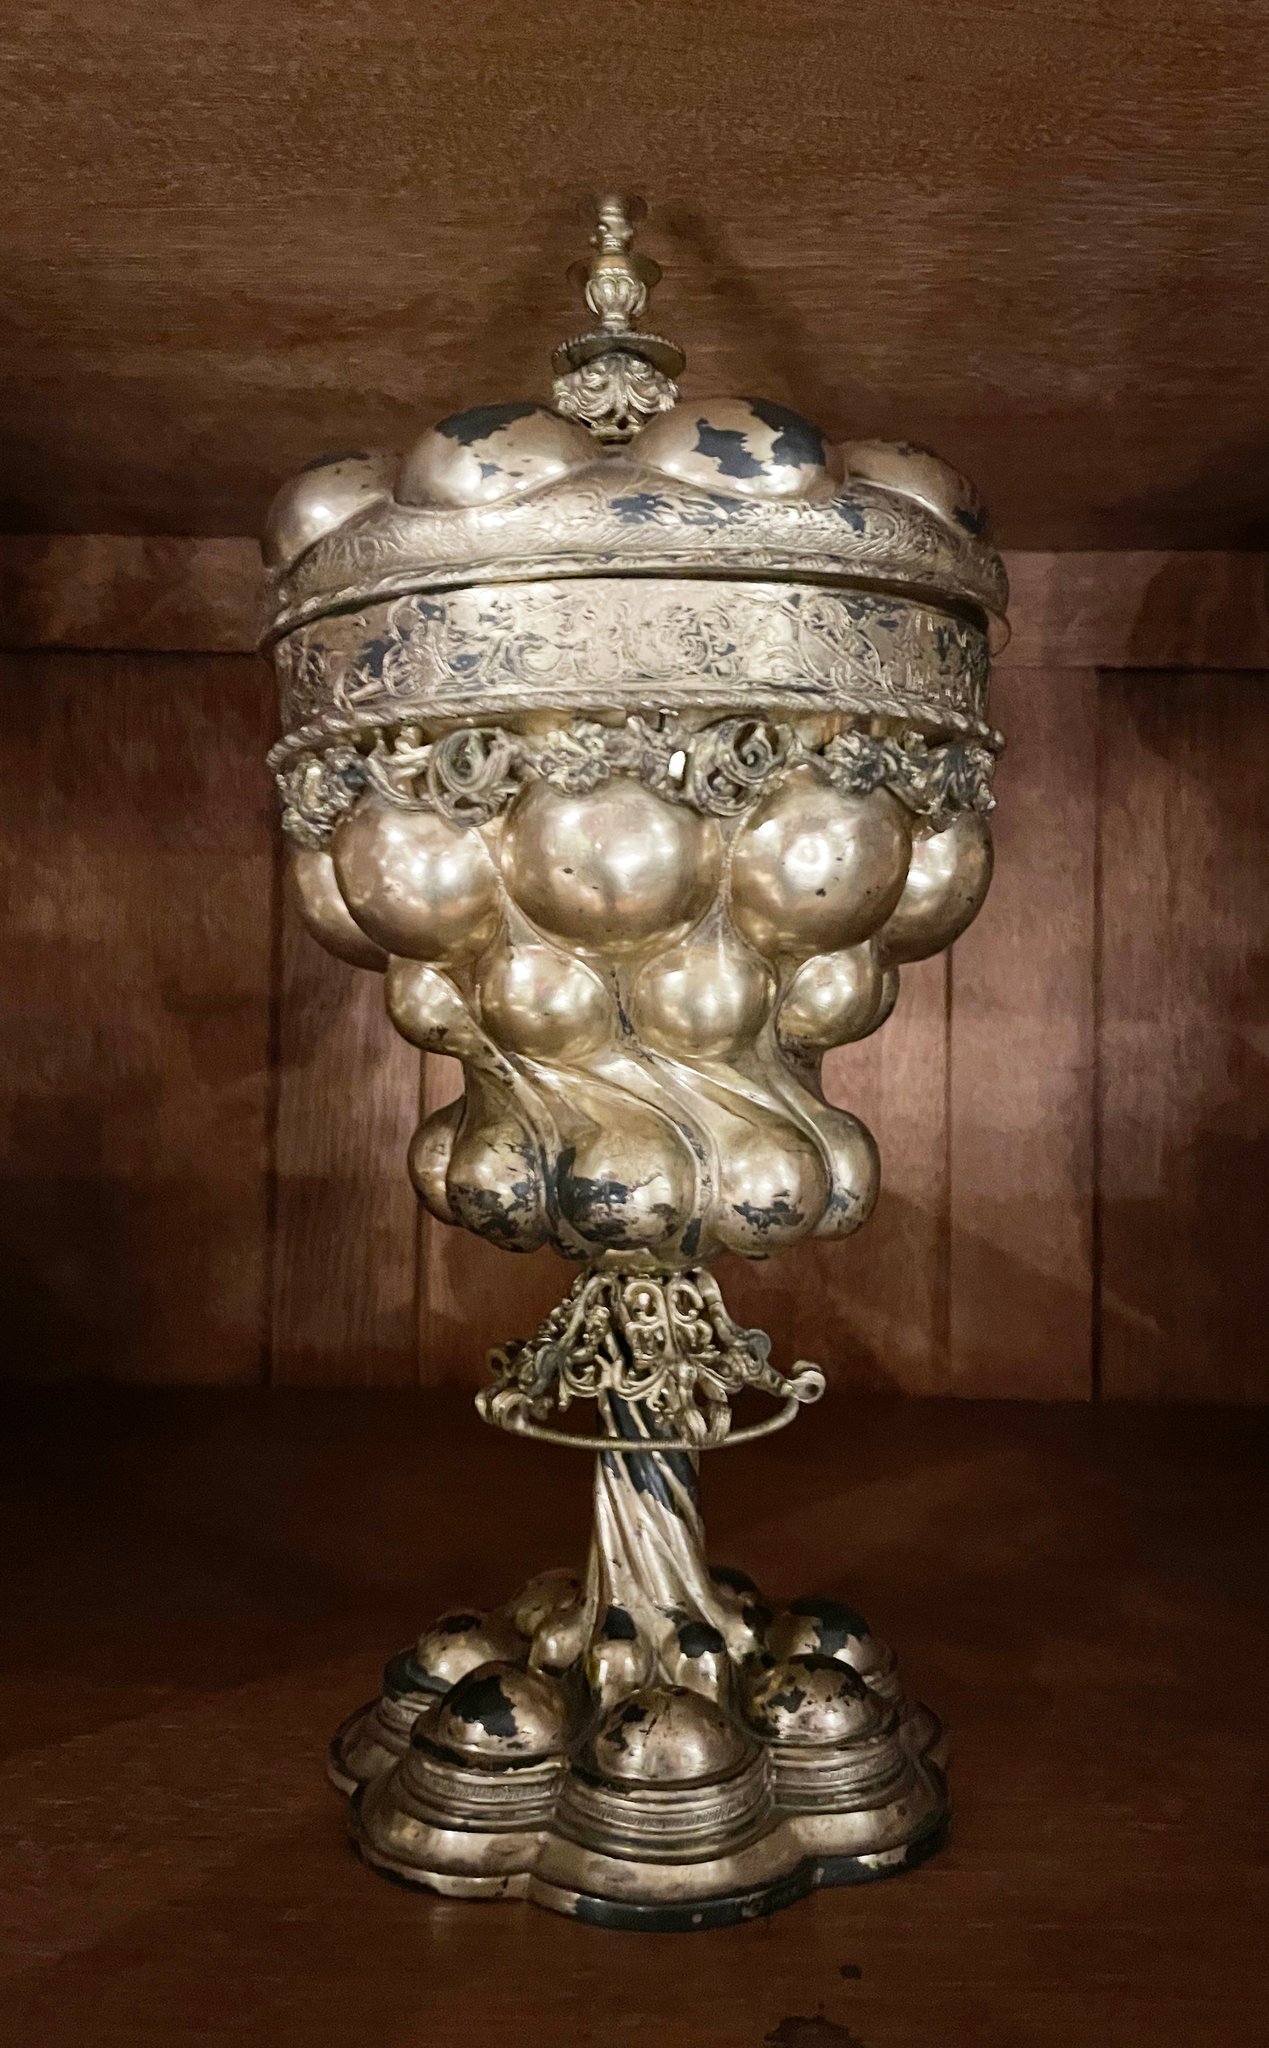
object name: cup with cover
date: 1801-1900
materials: metal, silver